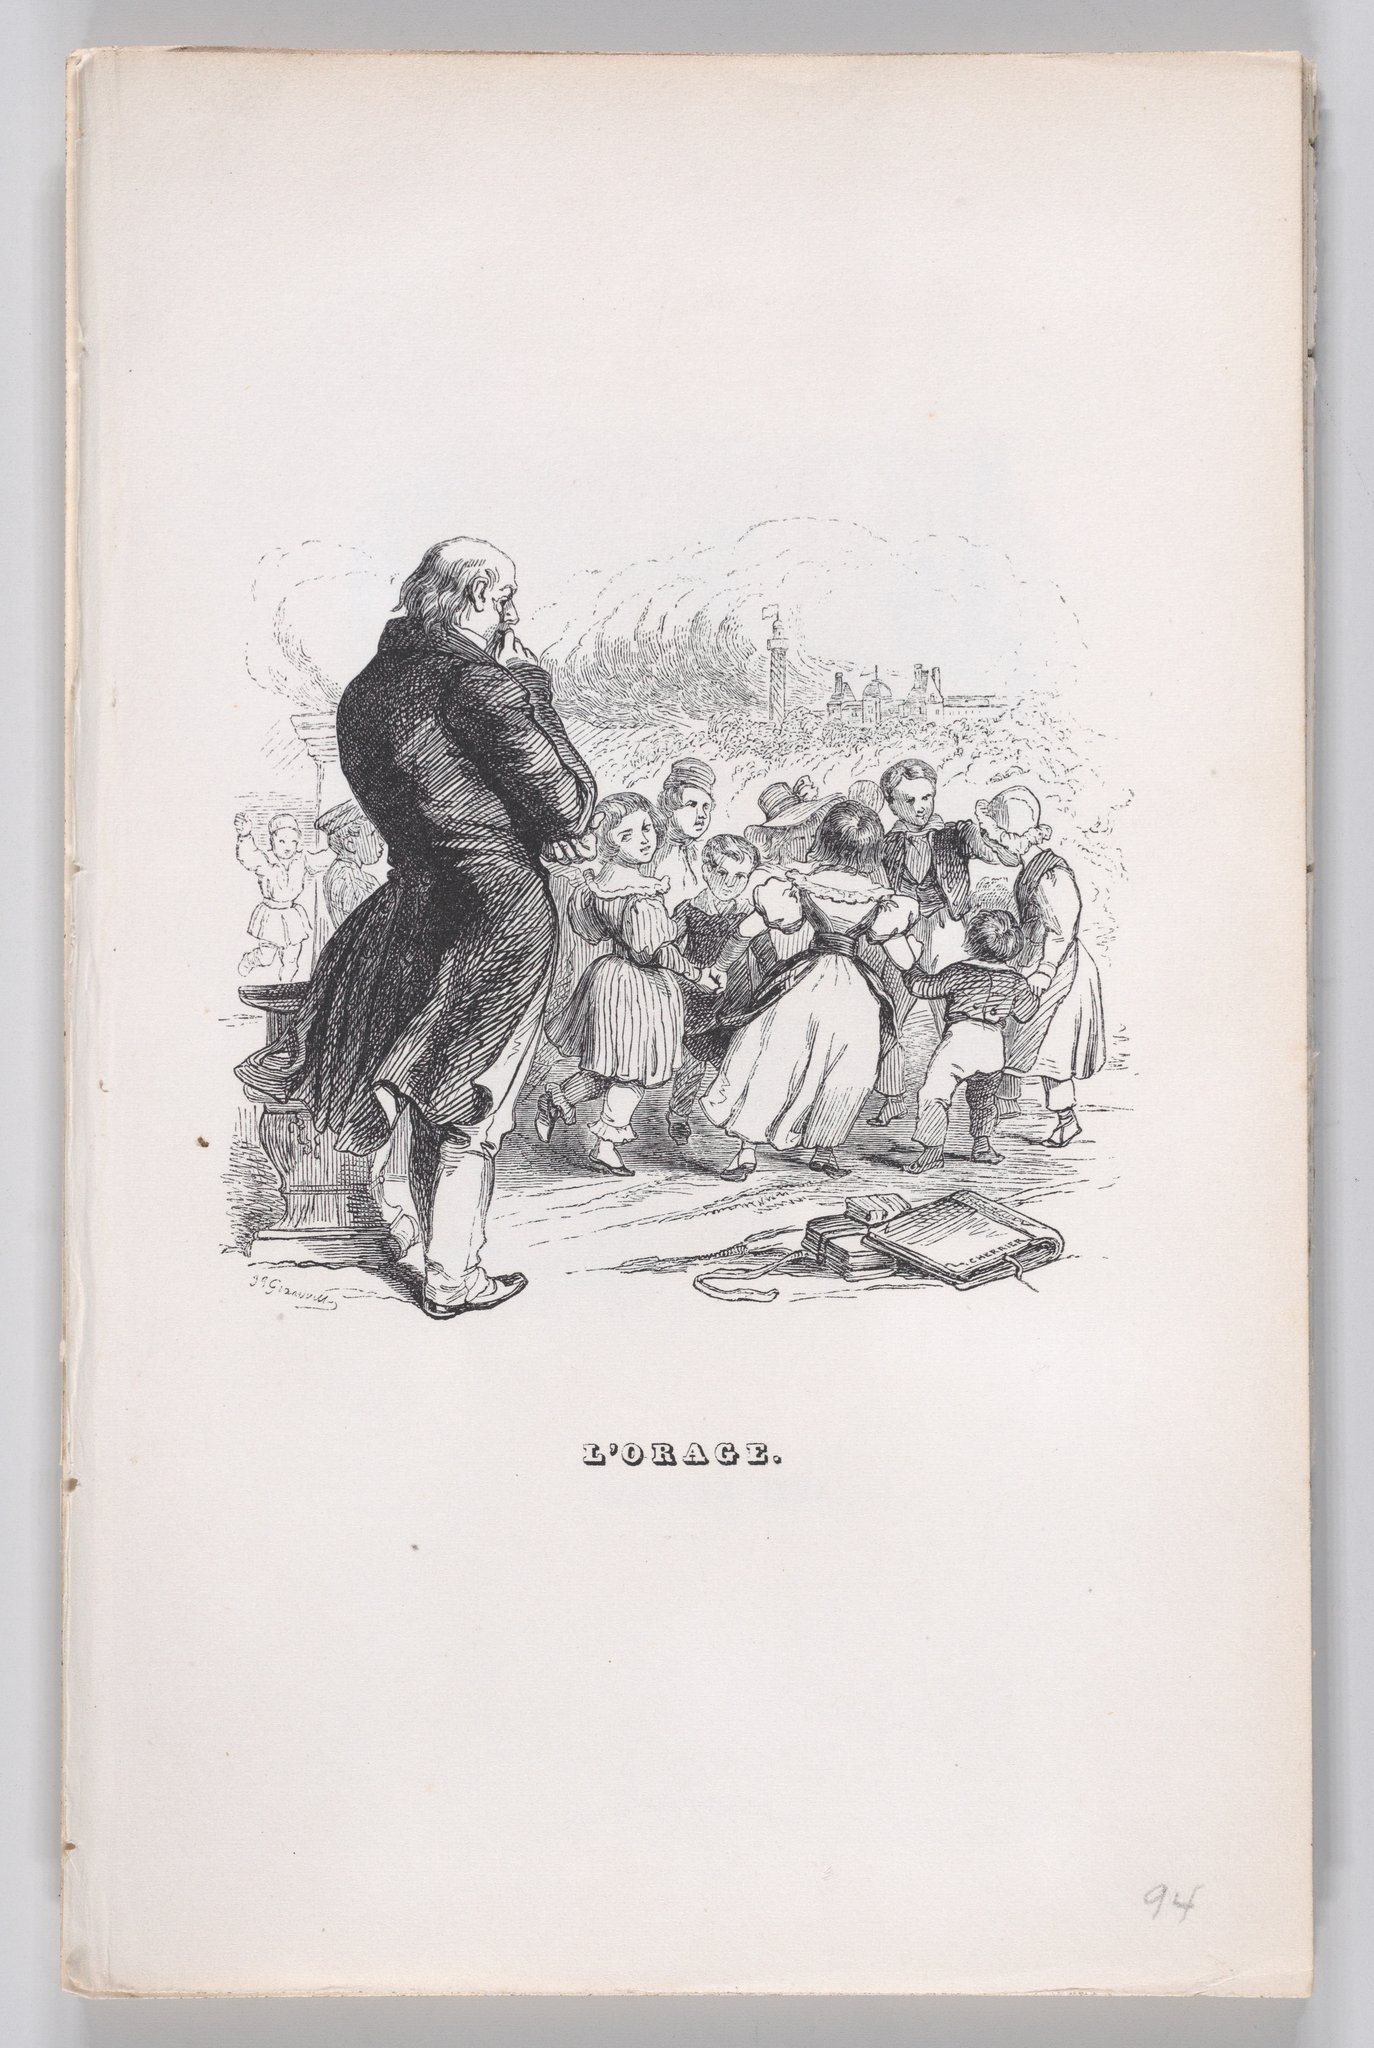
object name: print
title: The Storm, from "The Complete Works of Béranger"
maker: j. j. grandville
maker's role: illustrator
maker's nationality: french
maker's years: 1803-1847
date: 1836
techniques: engraving